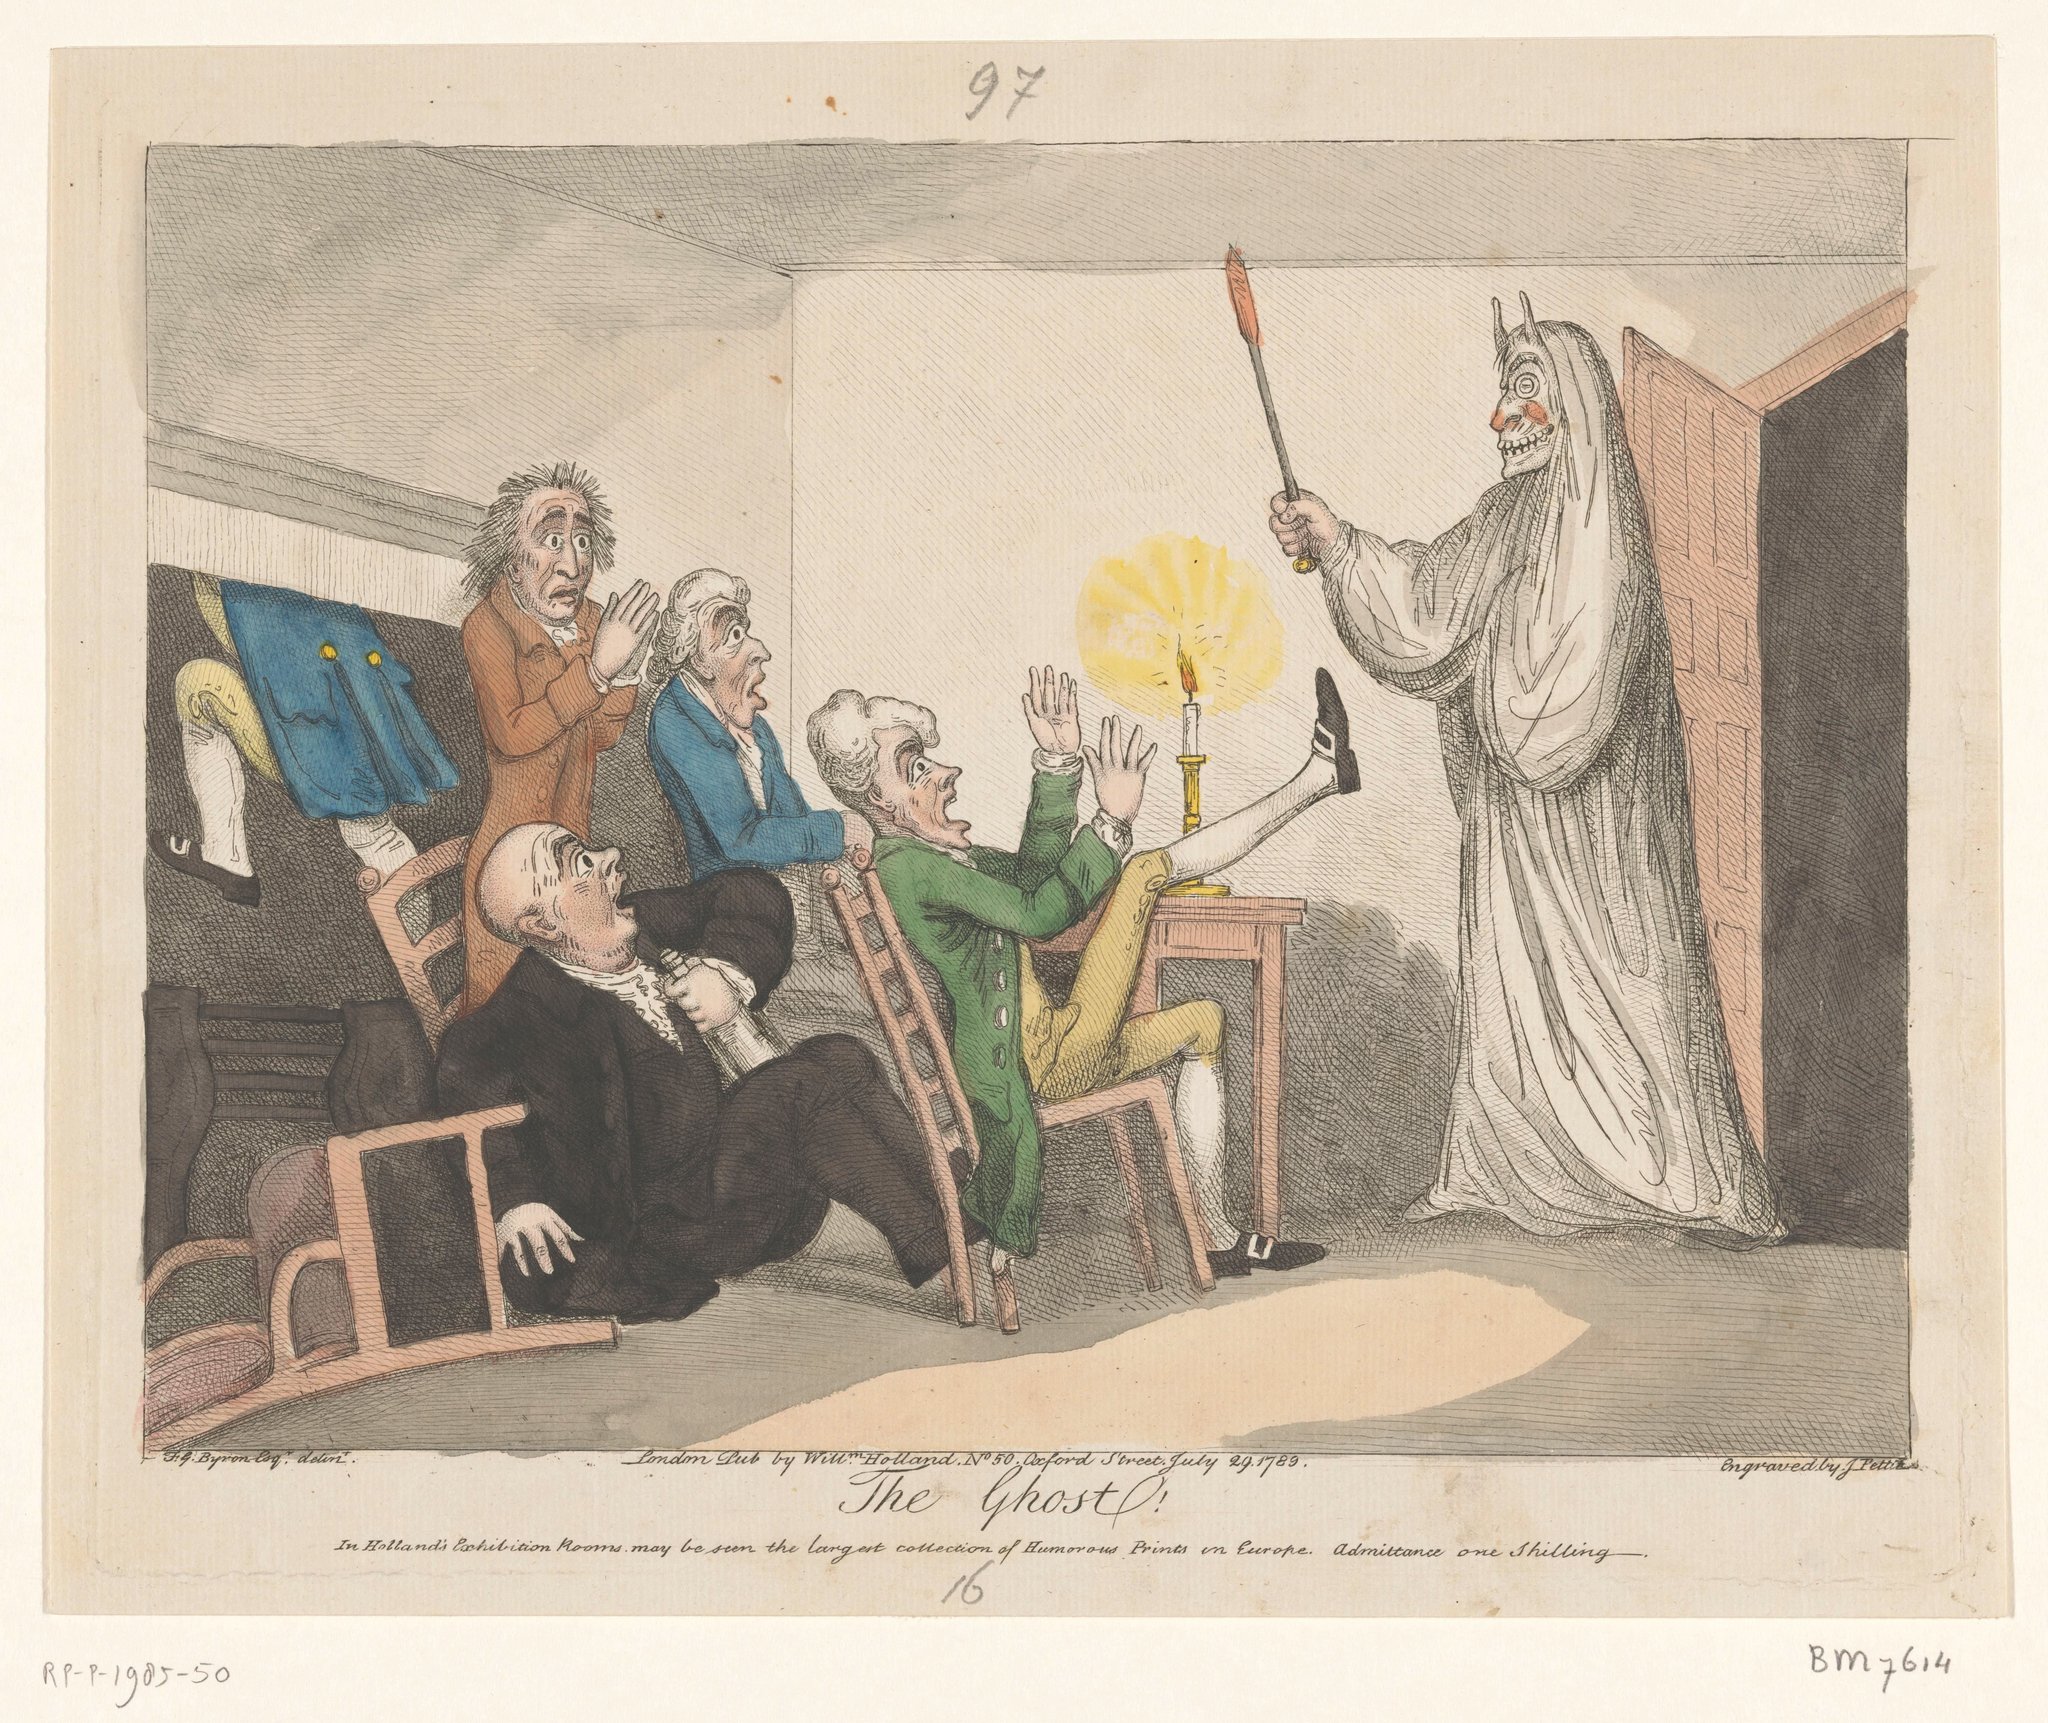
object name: print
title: Het Spook!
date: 1789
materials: paper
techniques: etching, hand coloring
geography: england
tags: materialization, appearance of spirit or ghost, political caricatures and satires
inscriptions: collector's mark: Lugt 2228, collector's mark: Lugt 2760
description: Spotprent waarin iemand verkleed als een geest of spook een groep van vier mannen angst aanjaagt, een vijfde is gevlucht.